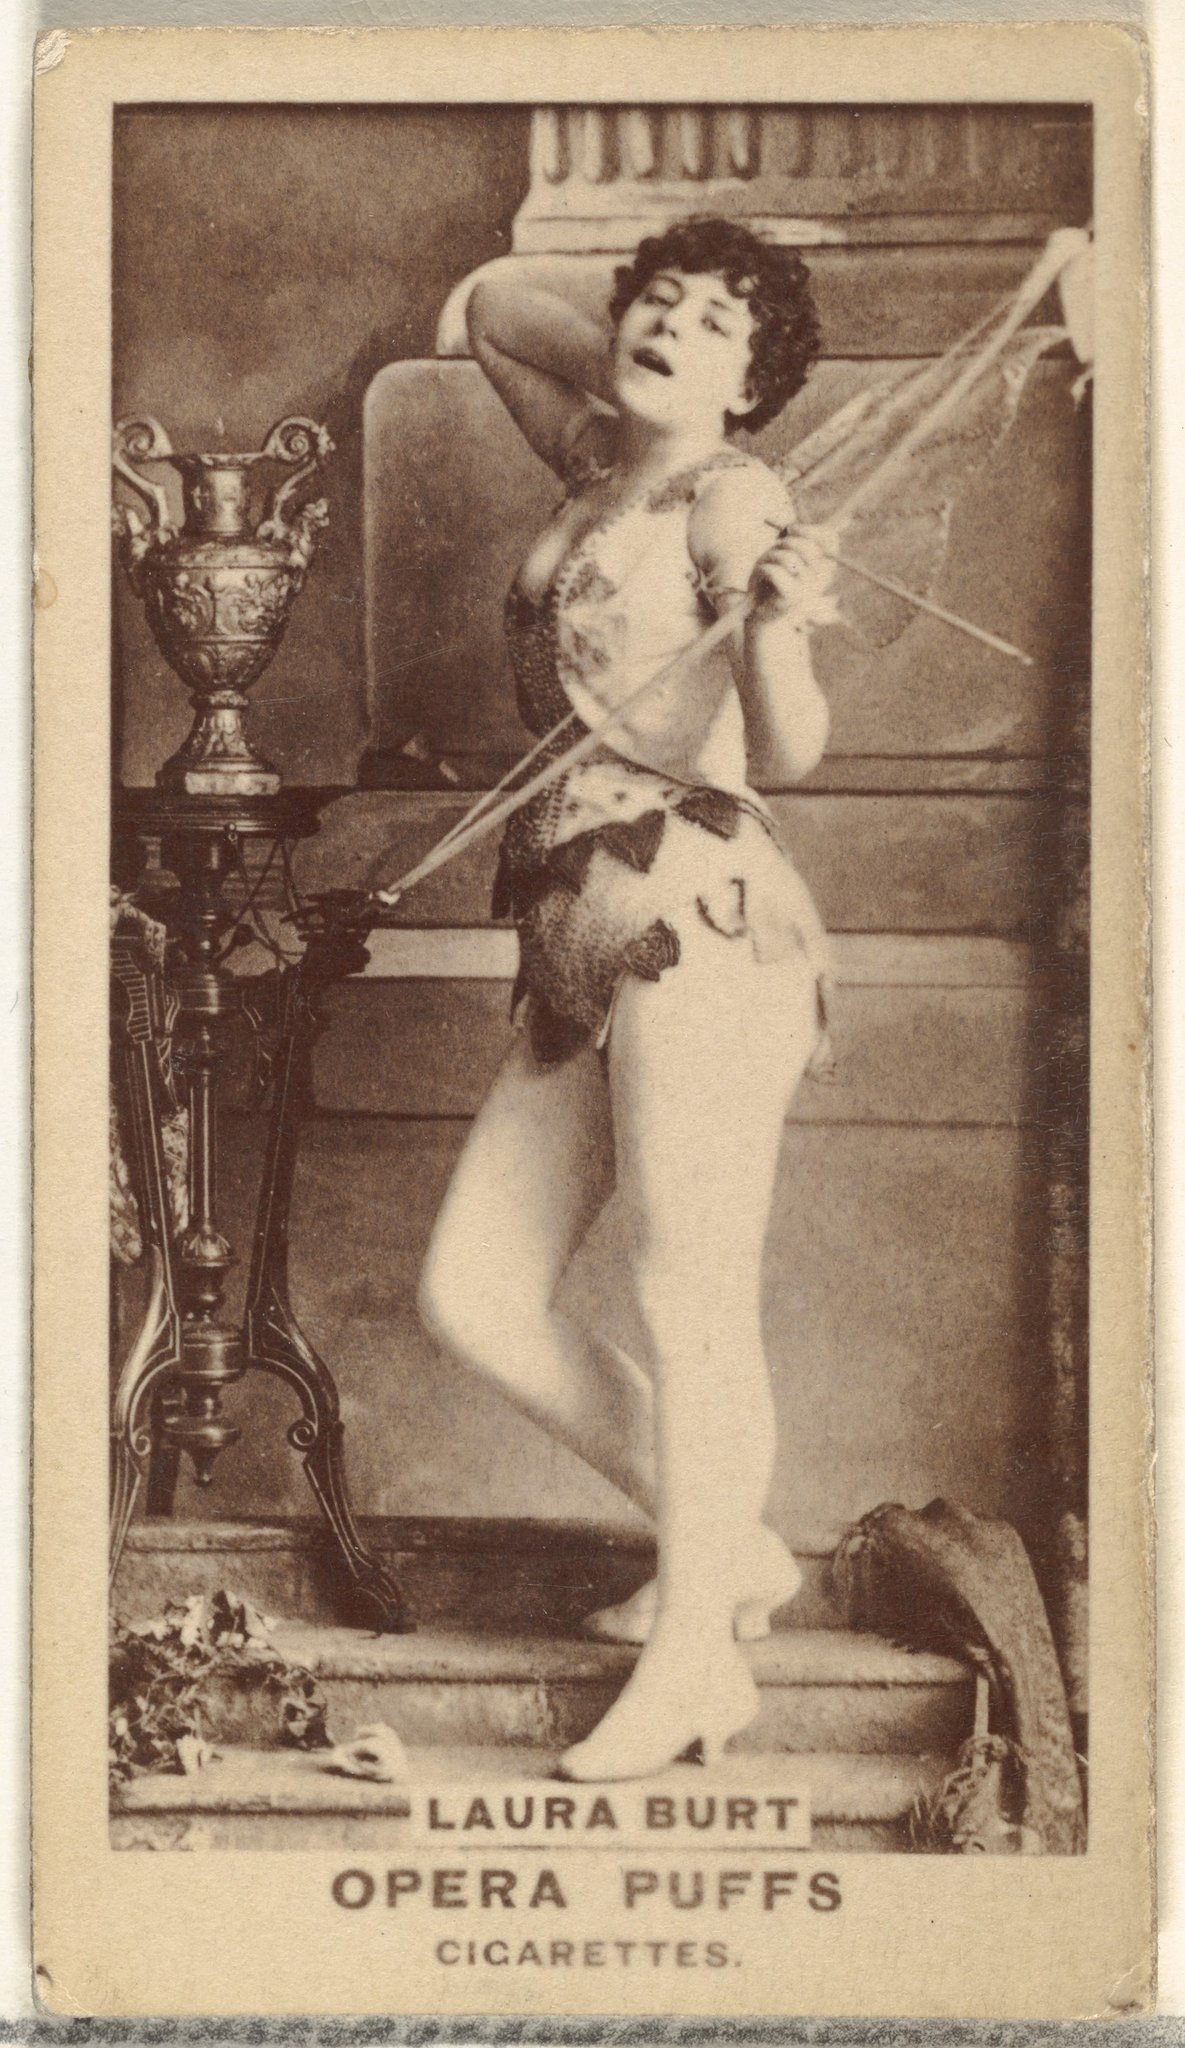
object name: photograph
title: Laura Burt, from the Actors and Actresses series (N171) for Opera Puffs Cigarettes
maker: goodwin & company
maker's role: publisher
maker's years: 1850-1950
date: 1886-1890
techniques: albumen silver print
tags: portraits,women,actresses